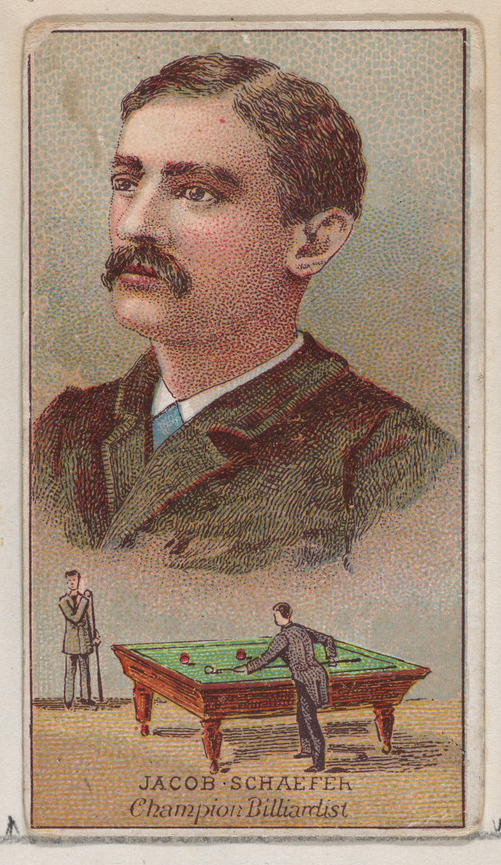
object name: print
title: Jacob Schaefer, Champion Billiardist, from the Champions of Games and Sports series (N184, Type 2) issued by W.S. Kimball & Co.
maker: w.s. kimball & co.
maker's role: publisher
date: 1887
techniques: color lithograph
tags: men,billiards